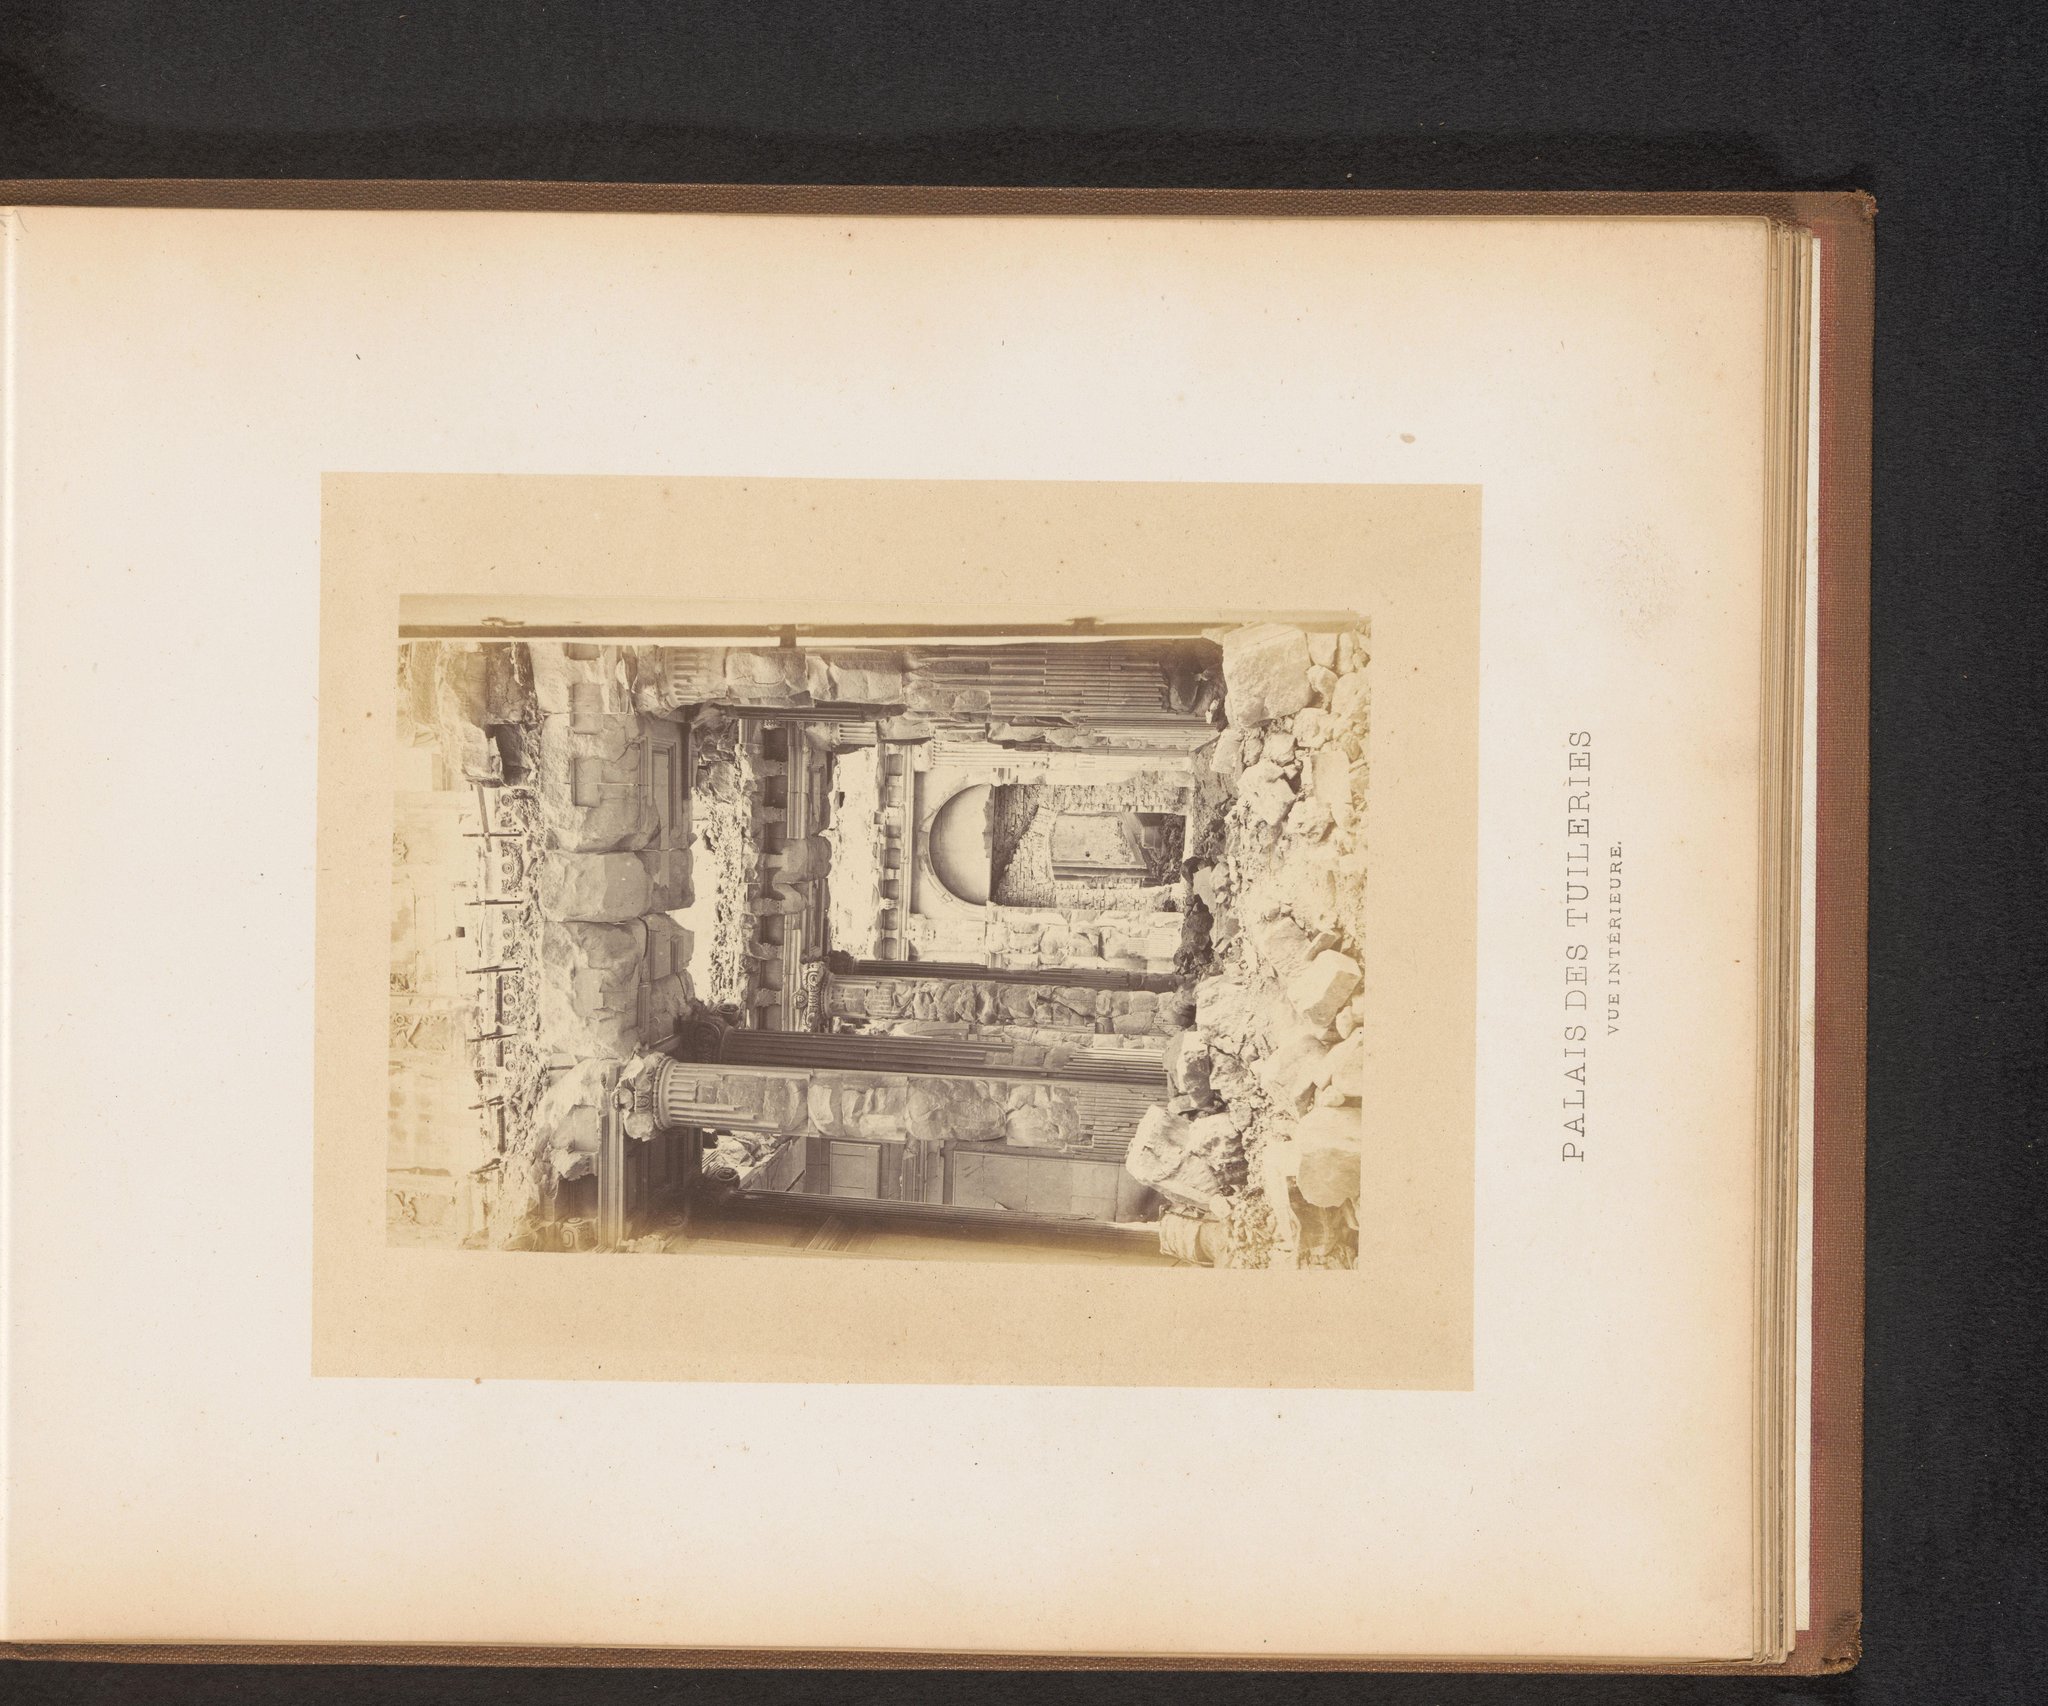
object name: page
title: Palais des Tuileries - vue interieure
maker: Anonymous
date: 1871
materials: photographic support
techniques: albumen print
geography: tuileries palace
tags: palace, ruin of a dwelling, house, castle, etc., tuileries palace